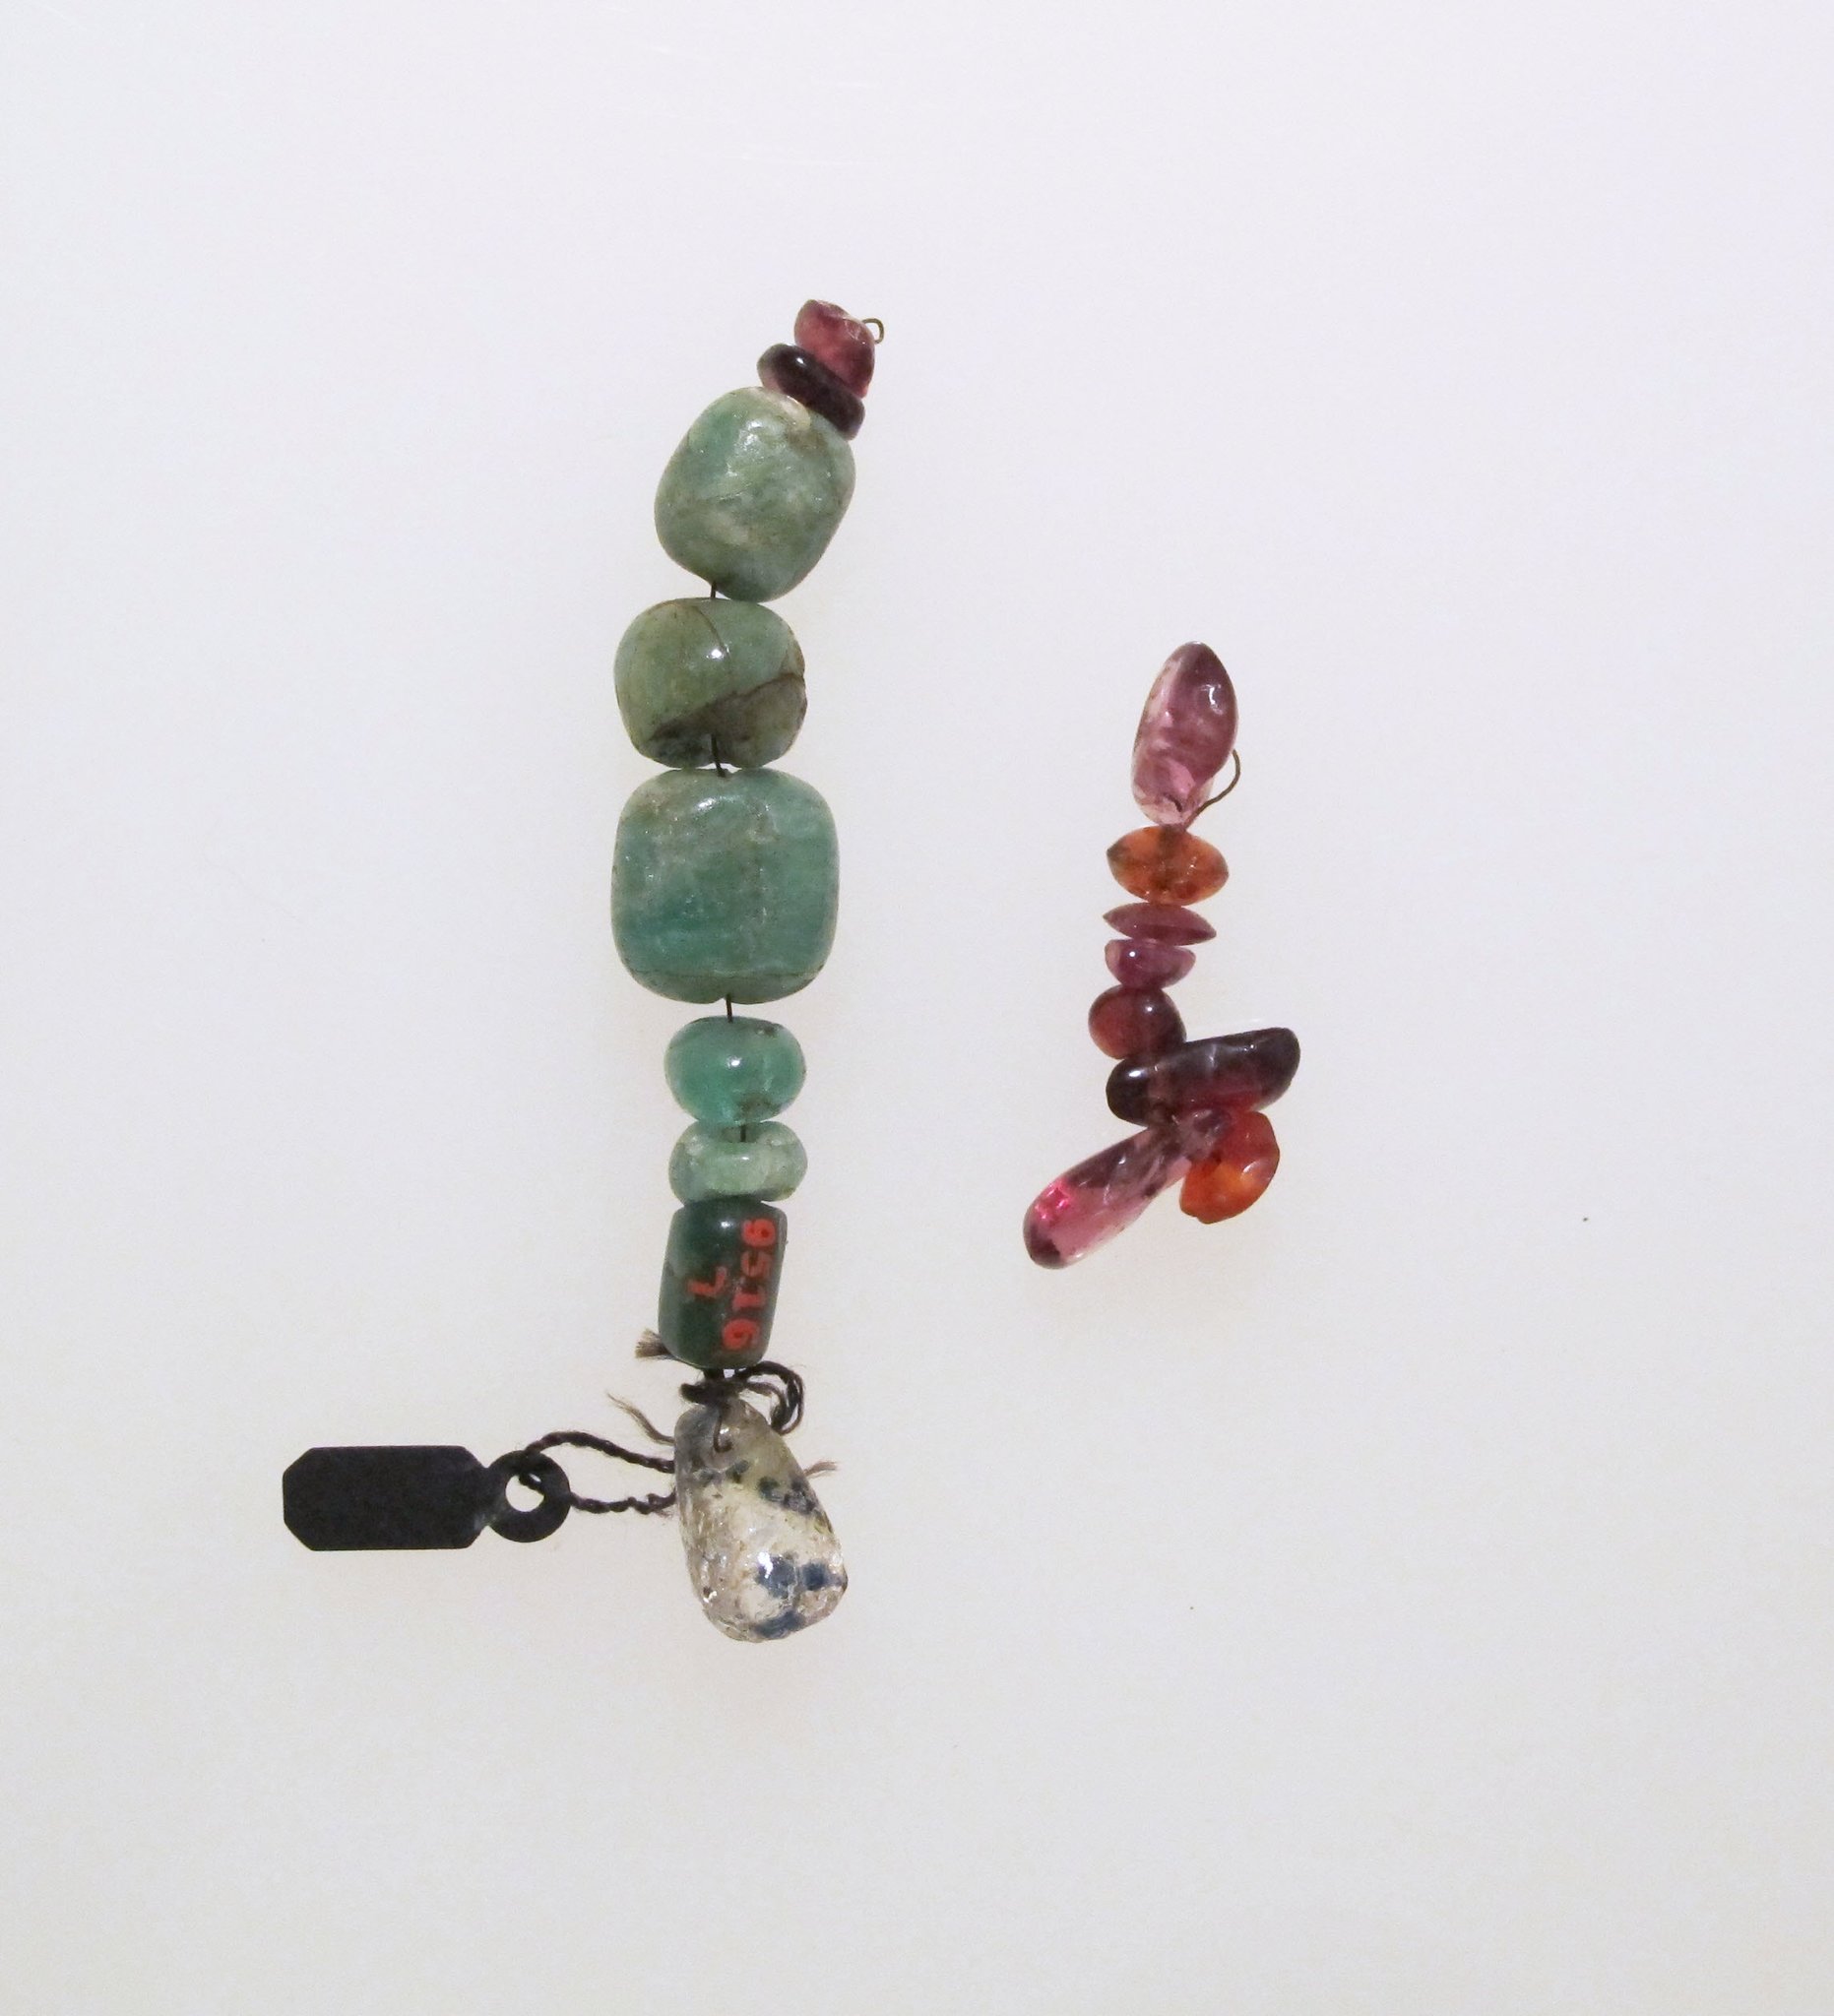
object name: necklace fragment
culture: greek or roman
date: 1-100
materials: glass